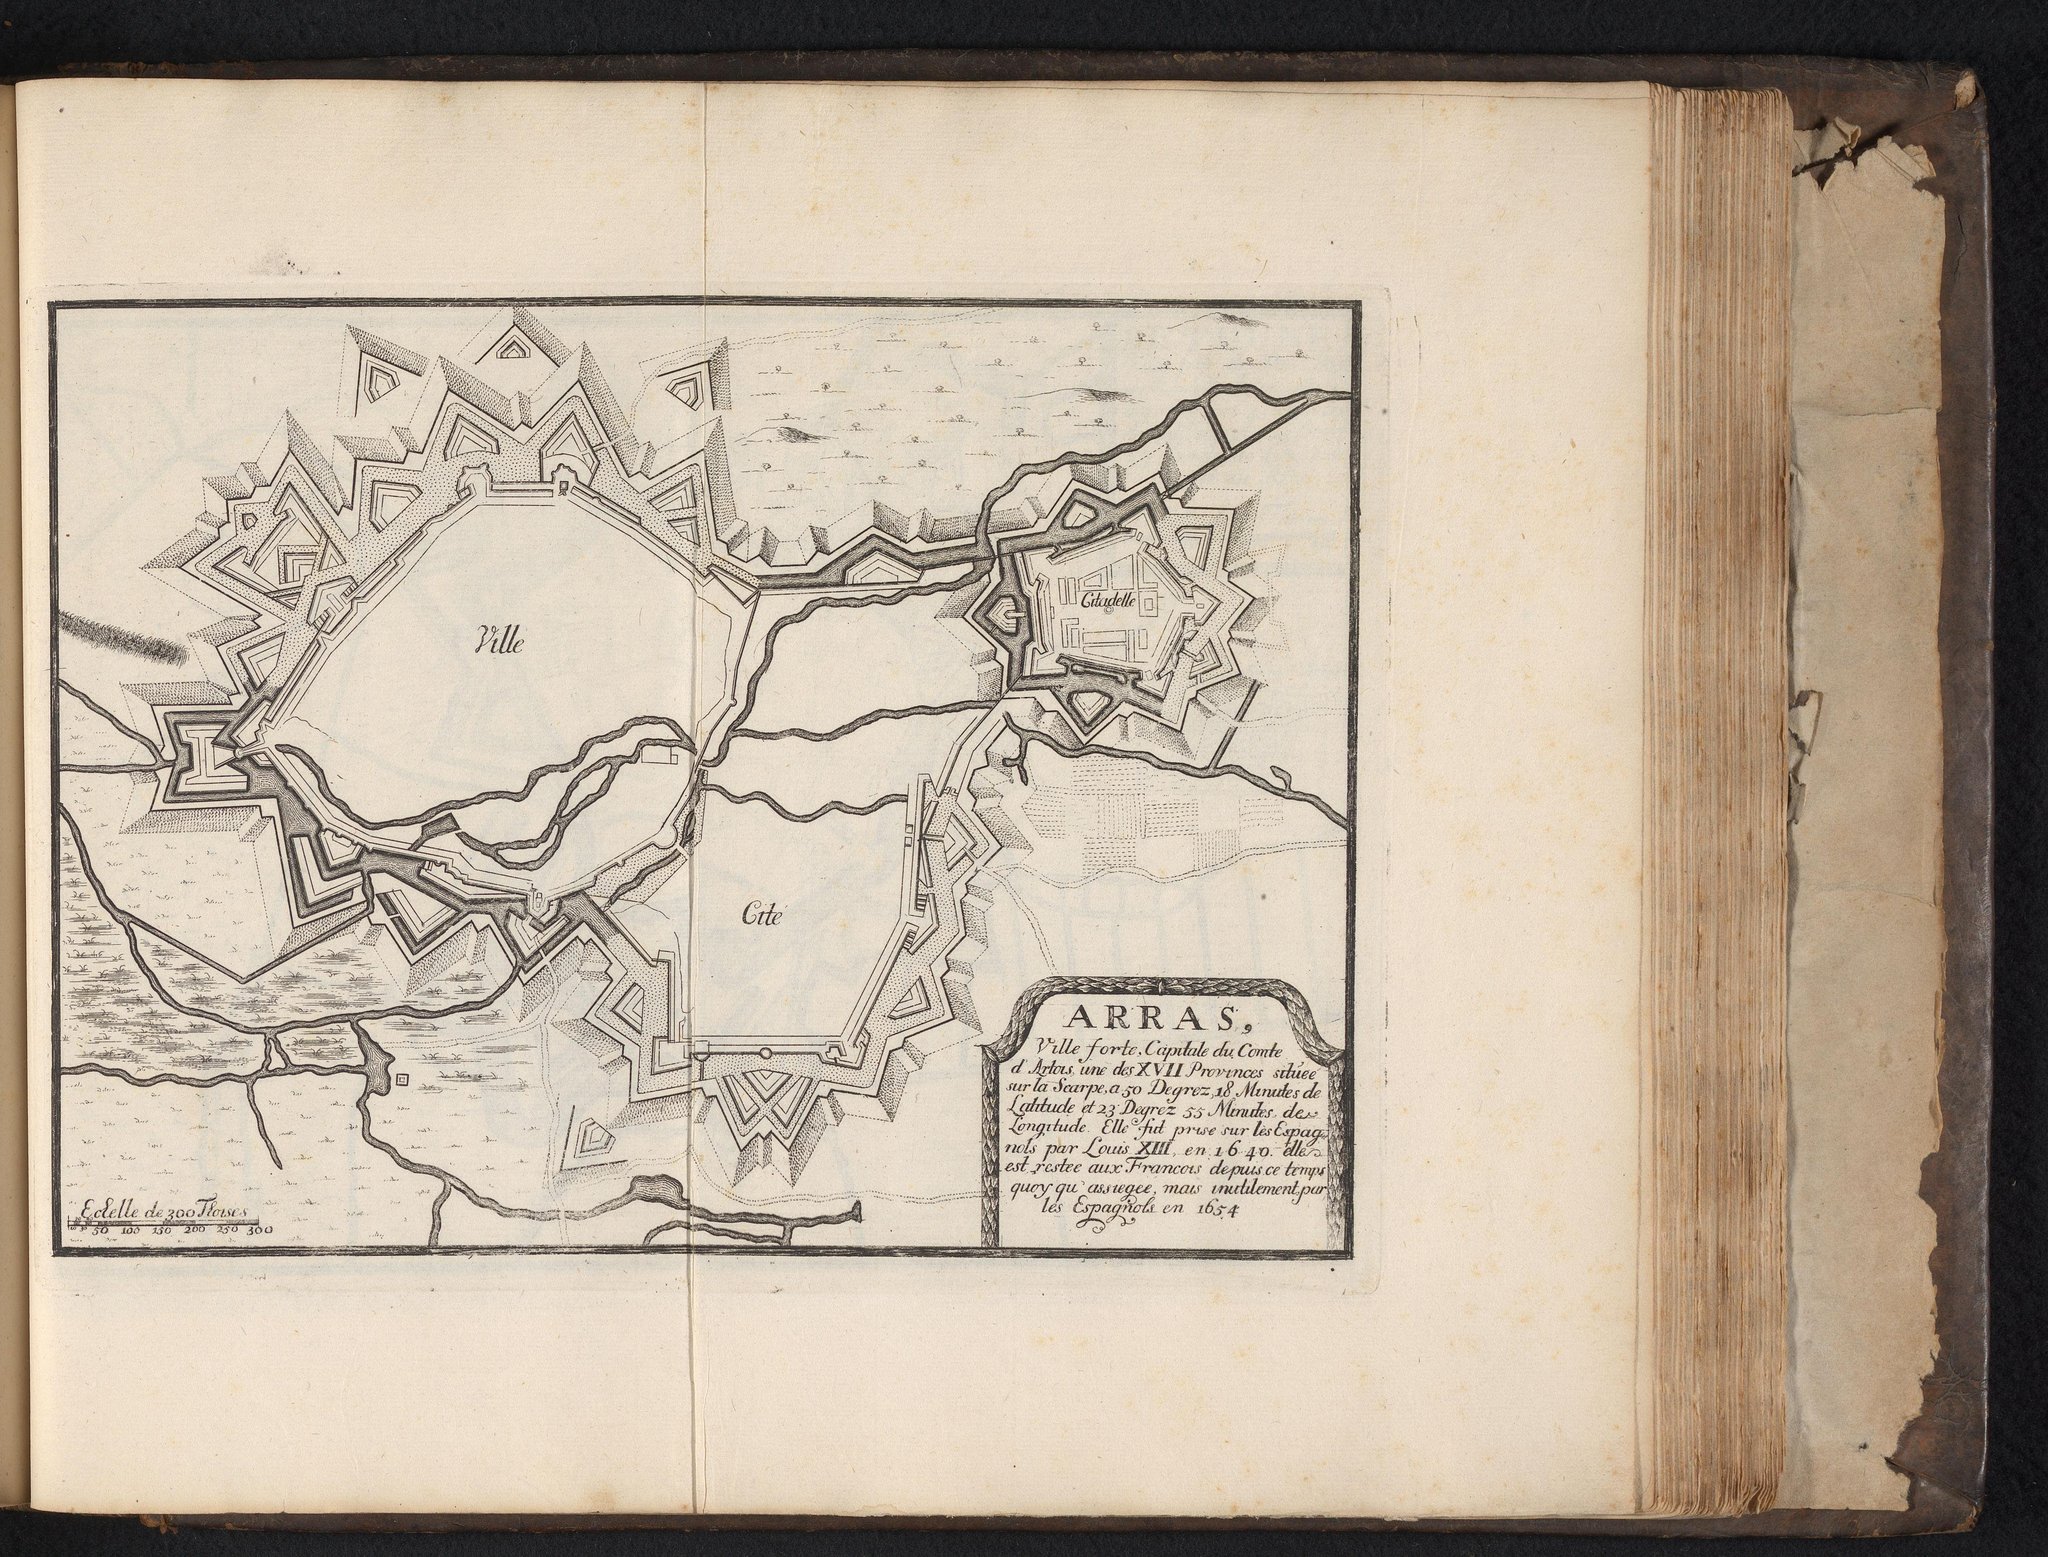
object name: map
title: Plattegrond van Arras, ca. 1693-1696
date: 1693-1696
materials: paper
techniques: etching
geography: france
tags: fortress, maps of cities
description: Plattegrond van de versterkingen om de Zuid-Nederlandse stad Arras (Atrecht). Onderdeel van het eerste van twee delen van het prentwerk: Le Theatre de la Guerre, dans les Pays-Bas, waarvan het titelblad uitgegeven is in 1696. Het prentwerk bestaat in totaal (beide delen) uit 52 platen met plannen (afkomstig van Sébastien Le Prestre, Seigneur de Vauban) van vermaarde sterke steden en vestingen in de Negenjarige Oorlog in de Nederlanden. Variant (kopie?) van de plaat die voorkomt in: Les forces de l'Europe, uitgegeven tussen 1693-1697. Titel en opschriften in het Frans.